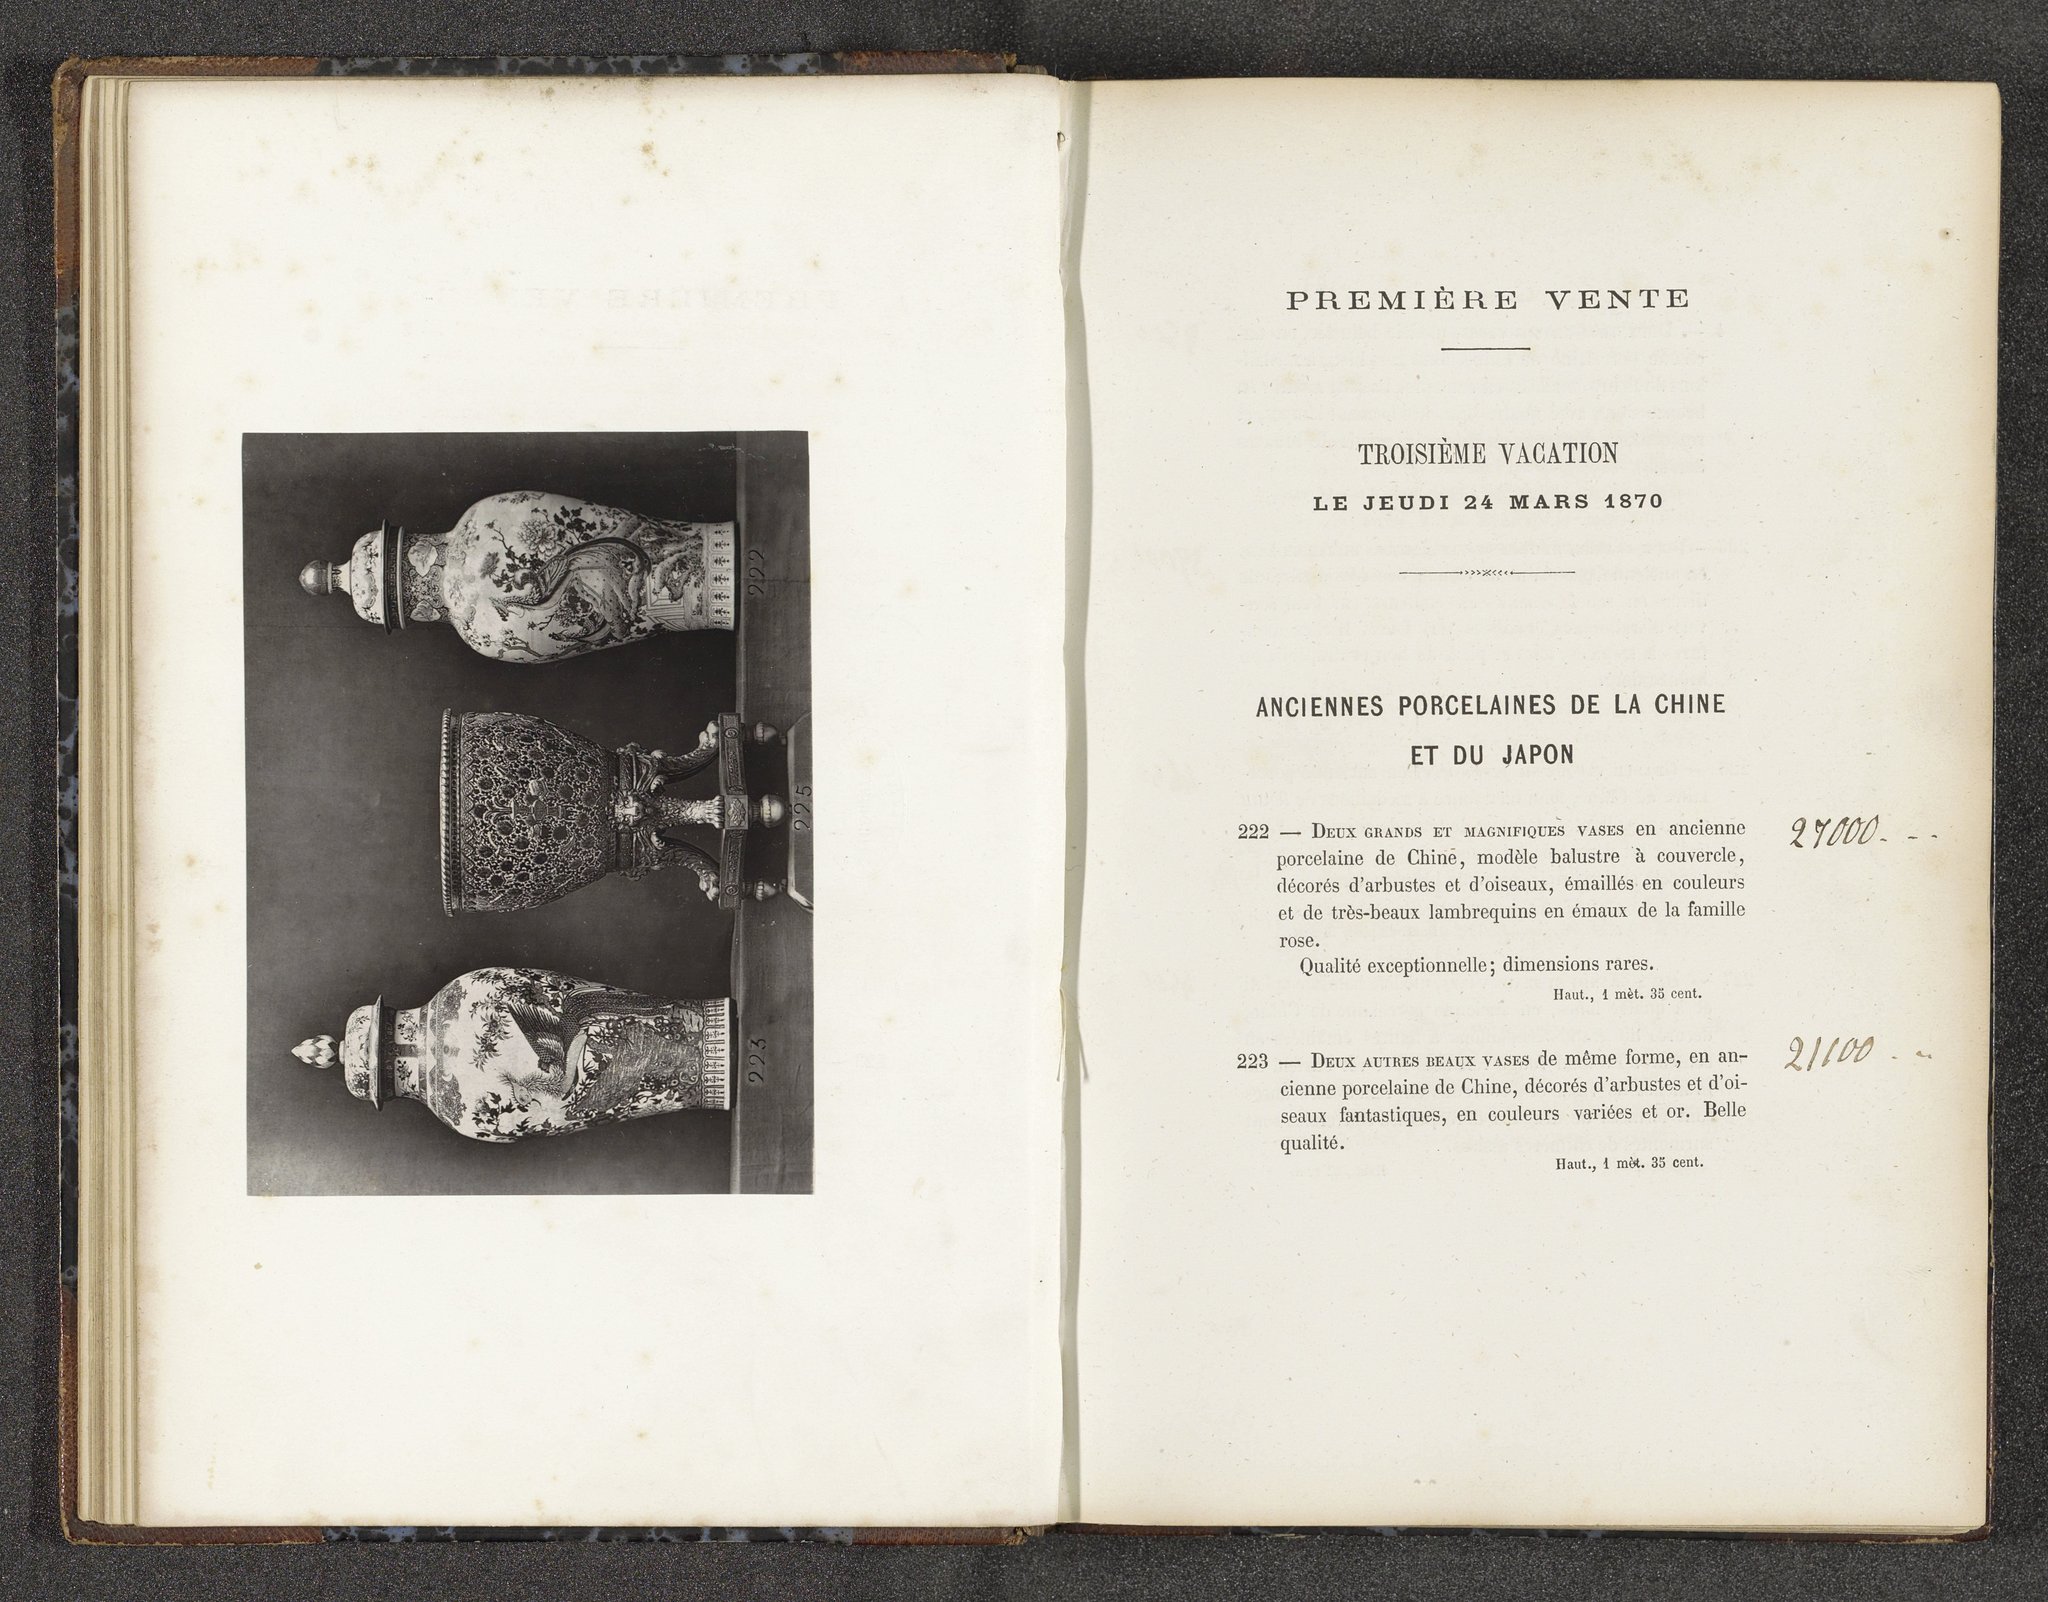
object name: page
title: Twee vazen en een bloempot van Chinees porselein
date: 1870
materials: paper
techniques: woodburytype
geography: paris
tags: container of ceramics: jar, jug, pot, vase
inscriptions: number: ‘223 225 222’, name: ‘De Goupil & Cie Imp. Photoglytique Paris’